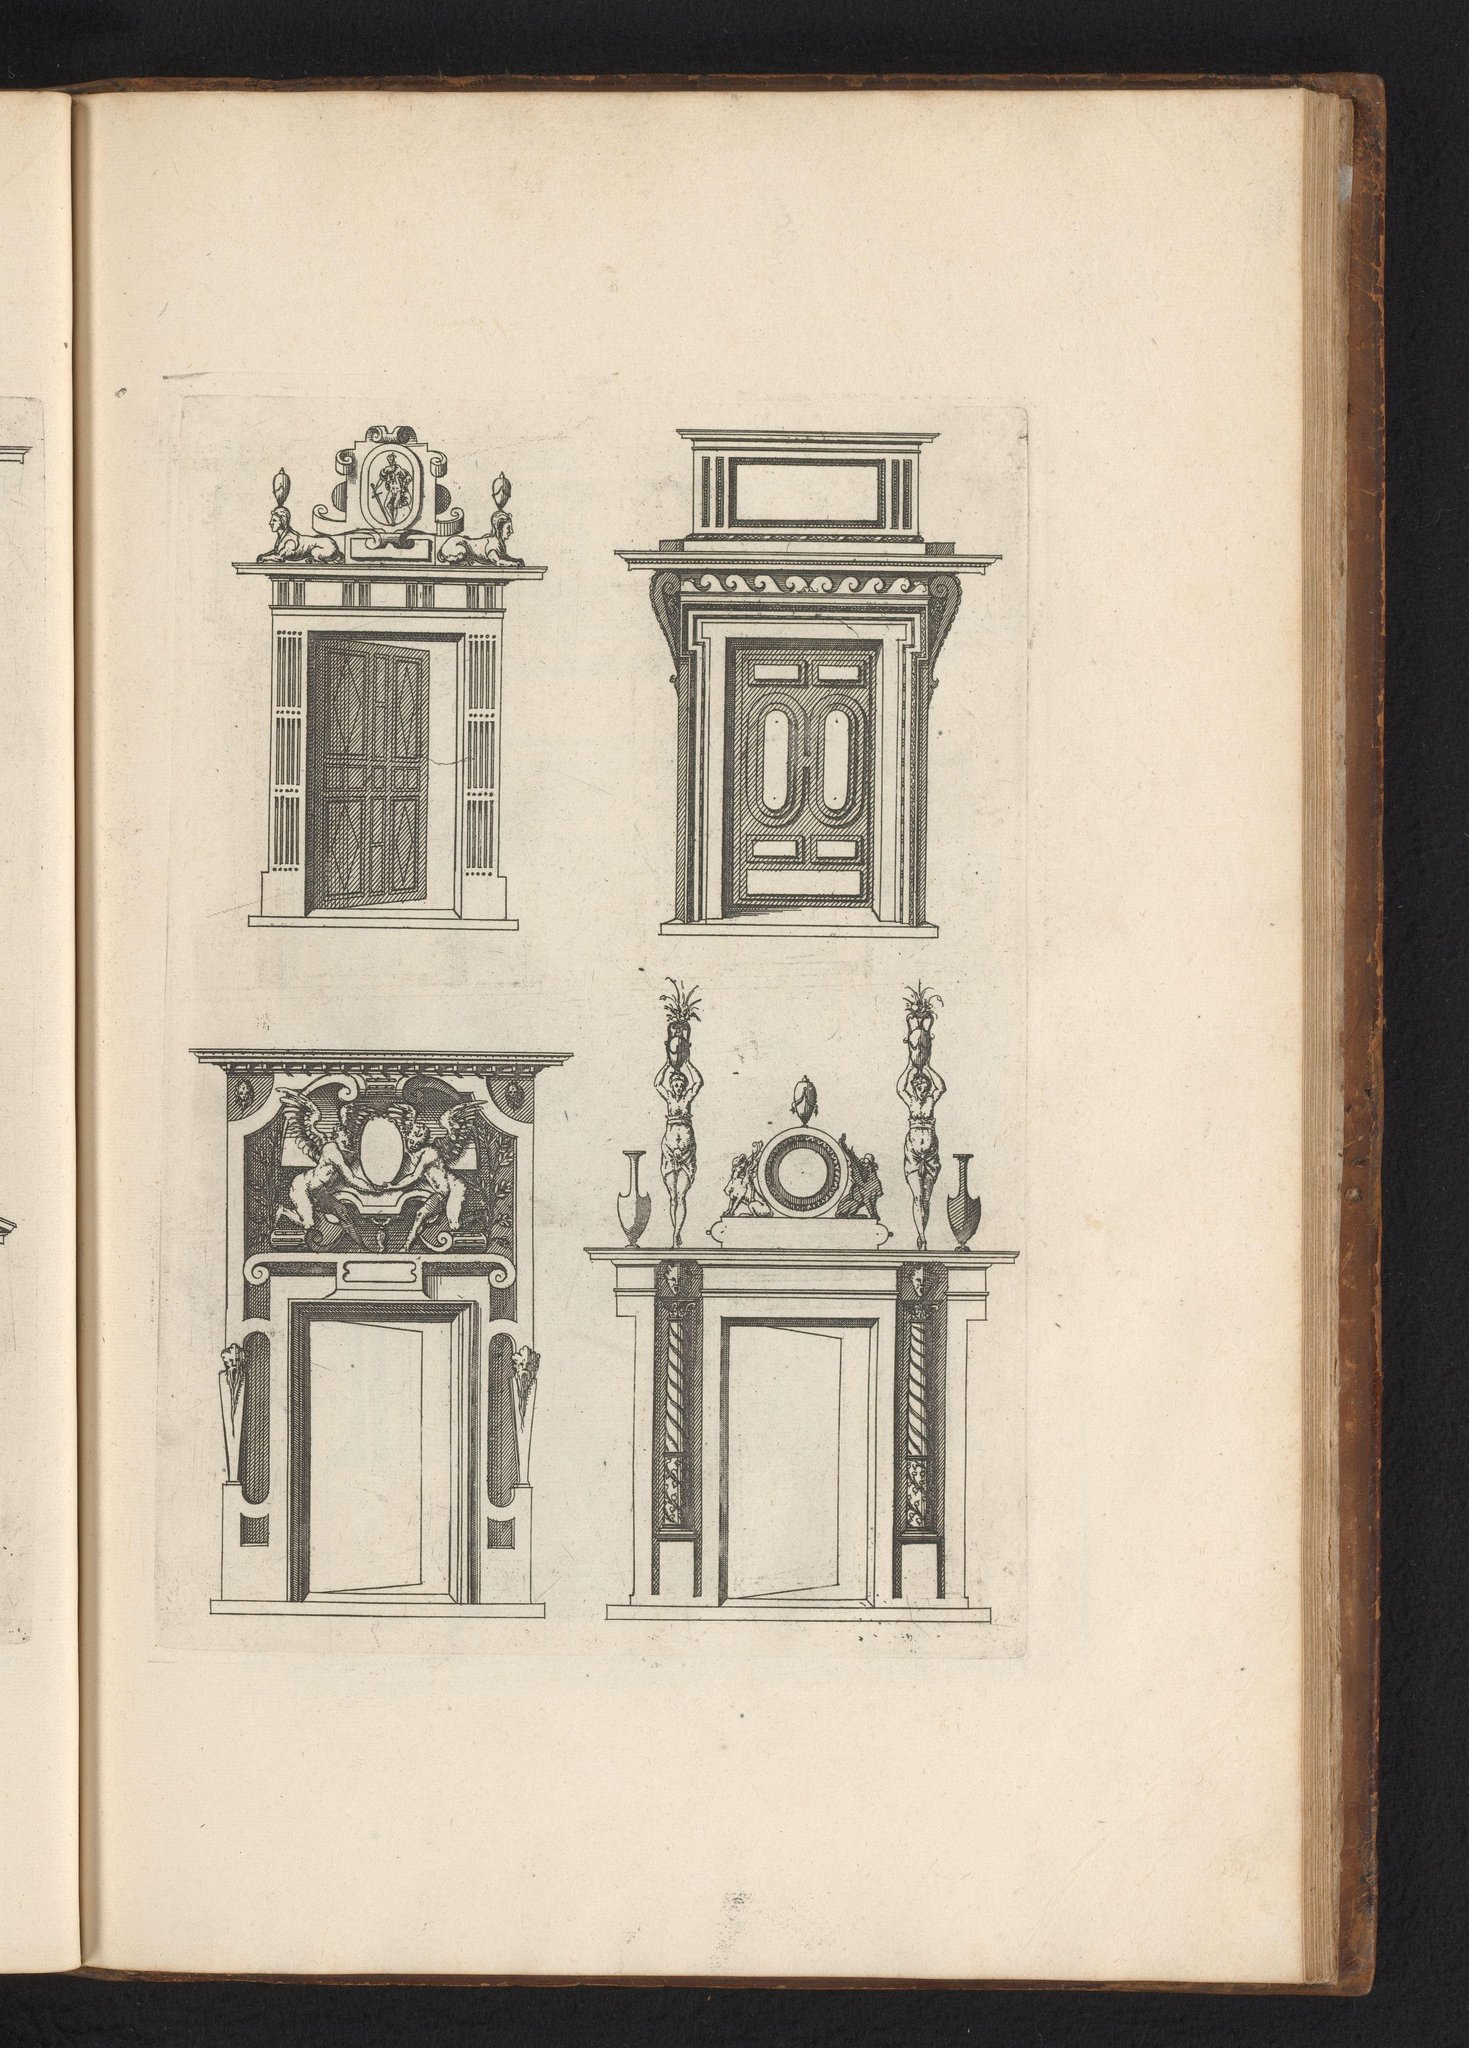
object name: ornament print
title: Vier poorten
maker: jacques androuet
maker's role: draughtsman, print maker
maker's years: 1515-1584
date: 1561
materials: paper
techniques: etching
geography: paris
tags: other architectural details: pediment, door, architectural design or model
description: Vier poorten bekroond met verschillende frontons. Onderdeel van 'Seconde livre d'architectvre' (1561): 64 etsen met geornamenteerde architectuuronderdelen.